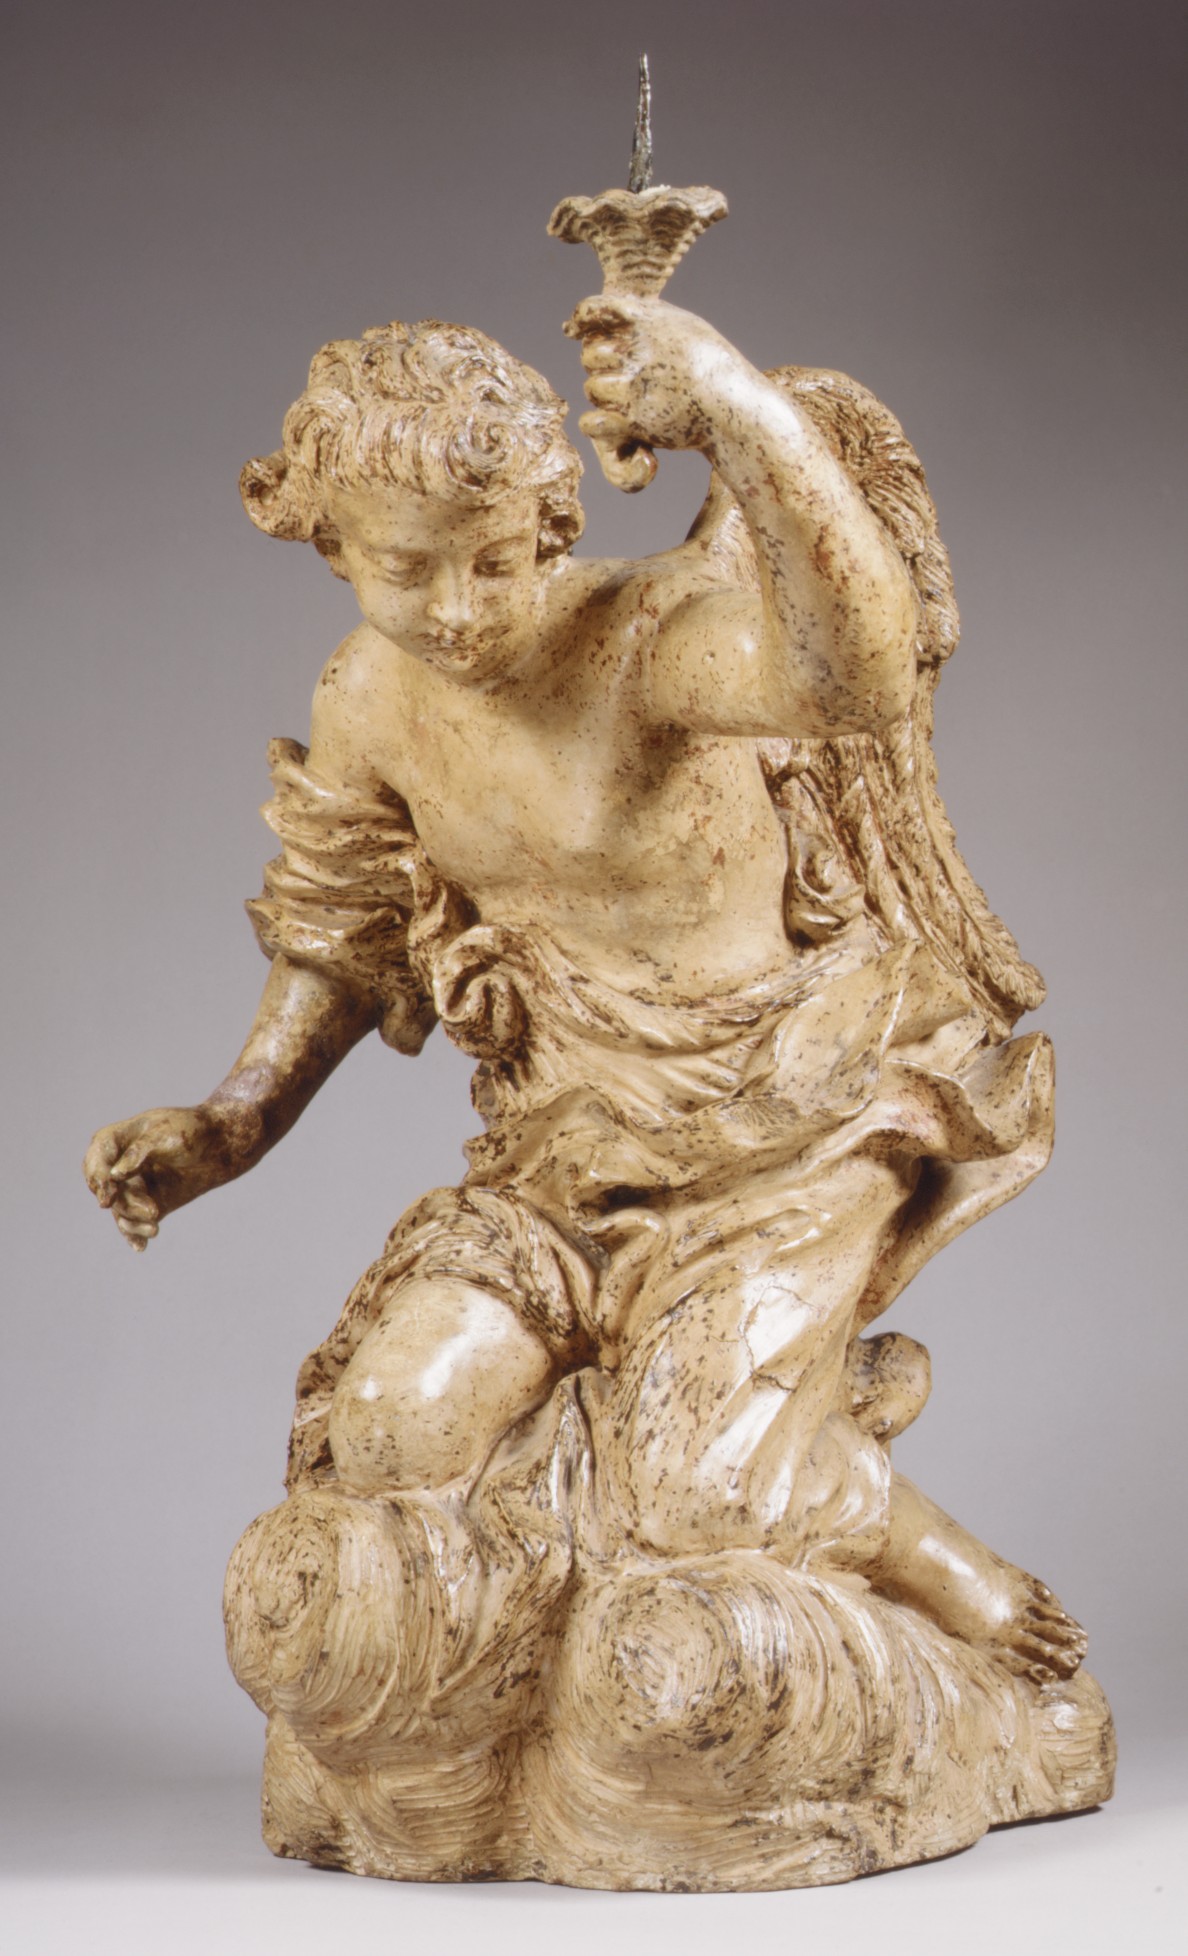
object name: statuette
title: Candle-bearing angel (one of a pair)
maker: giuseppe mazzuoli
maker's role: artist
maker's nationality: italian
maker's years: 1644-1725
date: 1677-1679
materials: paint, terracotta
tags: angels